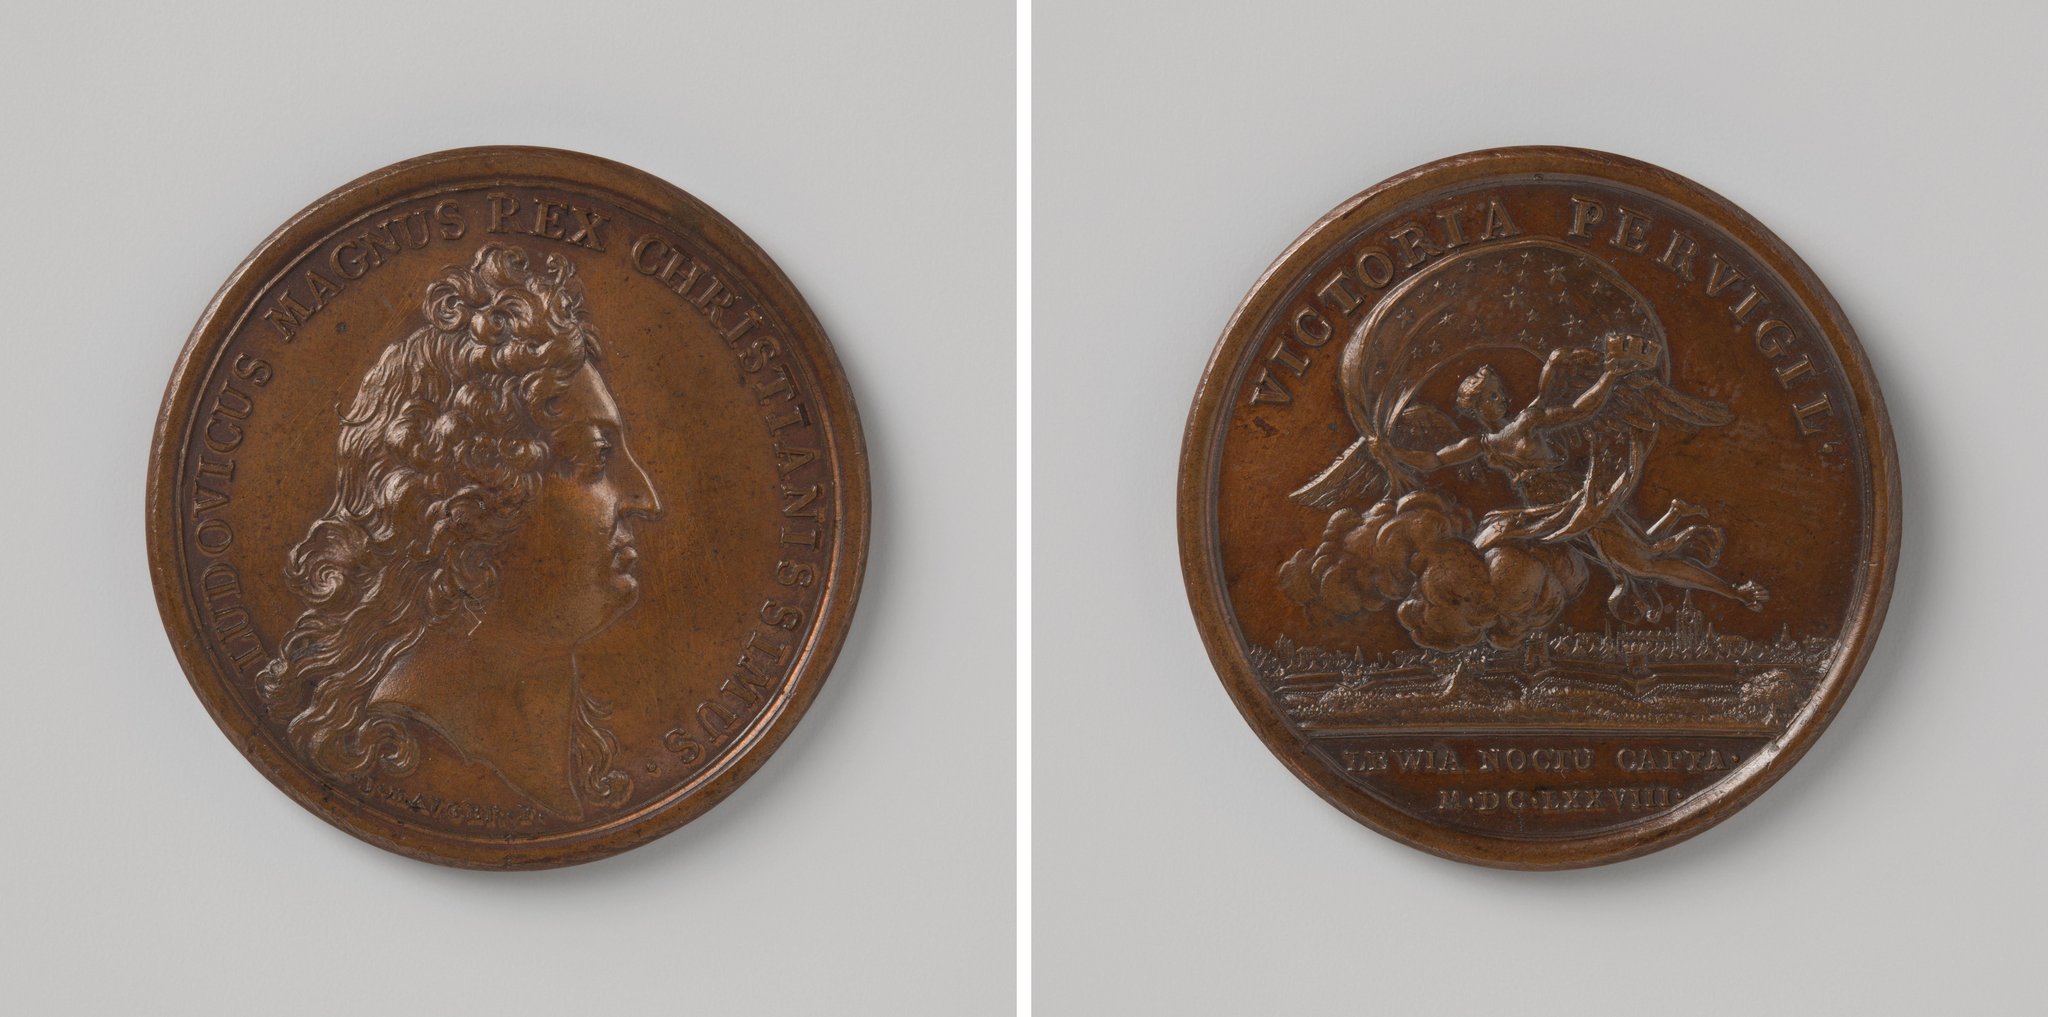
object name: history medal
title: Leeuwe bij nacht door de Fransen ingenomen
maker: jean mauger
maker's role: medailleur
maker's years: 1648-1722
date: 1699-1703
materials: bronze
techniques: striking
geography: paris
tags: lodewijk xiv (koning van frankrijk), brabant, zoutleeuw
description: Bronzen penning. Voorzijde: borststuk man binnen omschrift. Keerzijde: Overwinning met sluier van de nacht en kroon boven de ingenomen stad binnen omschrift; afsnede: opschrift